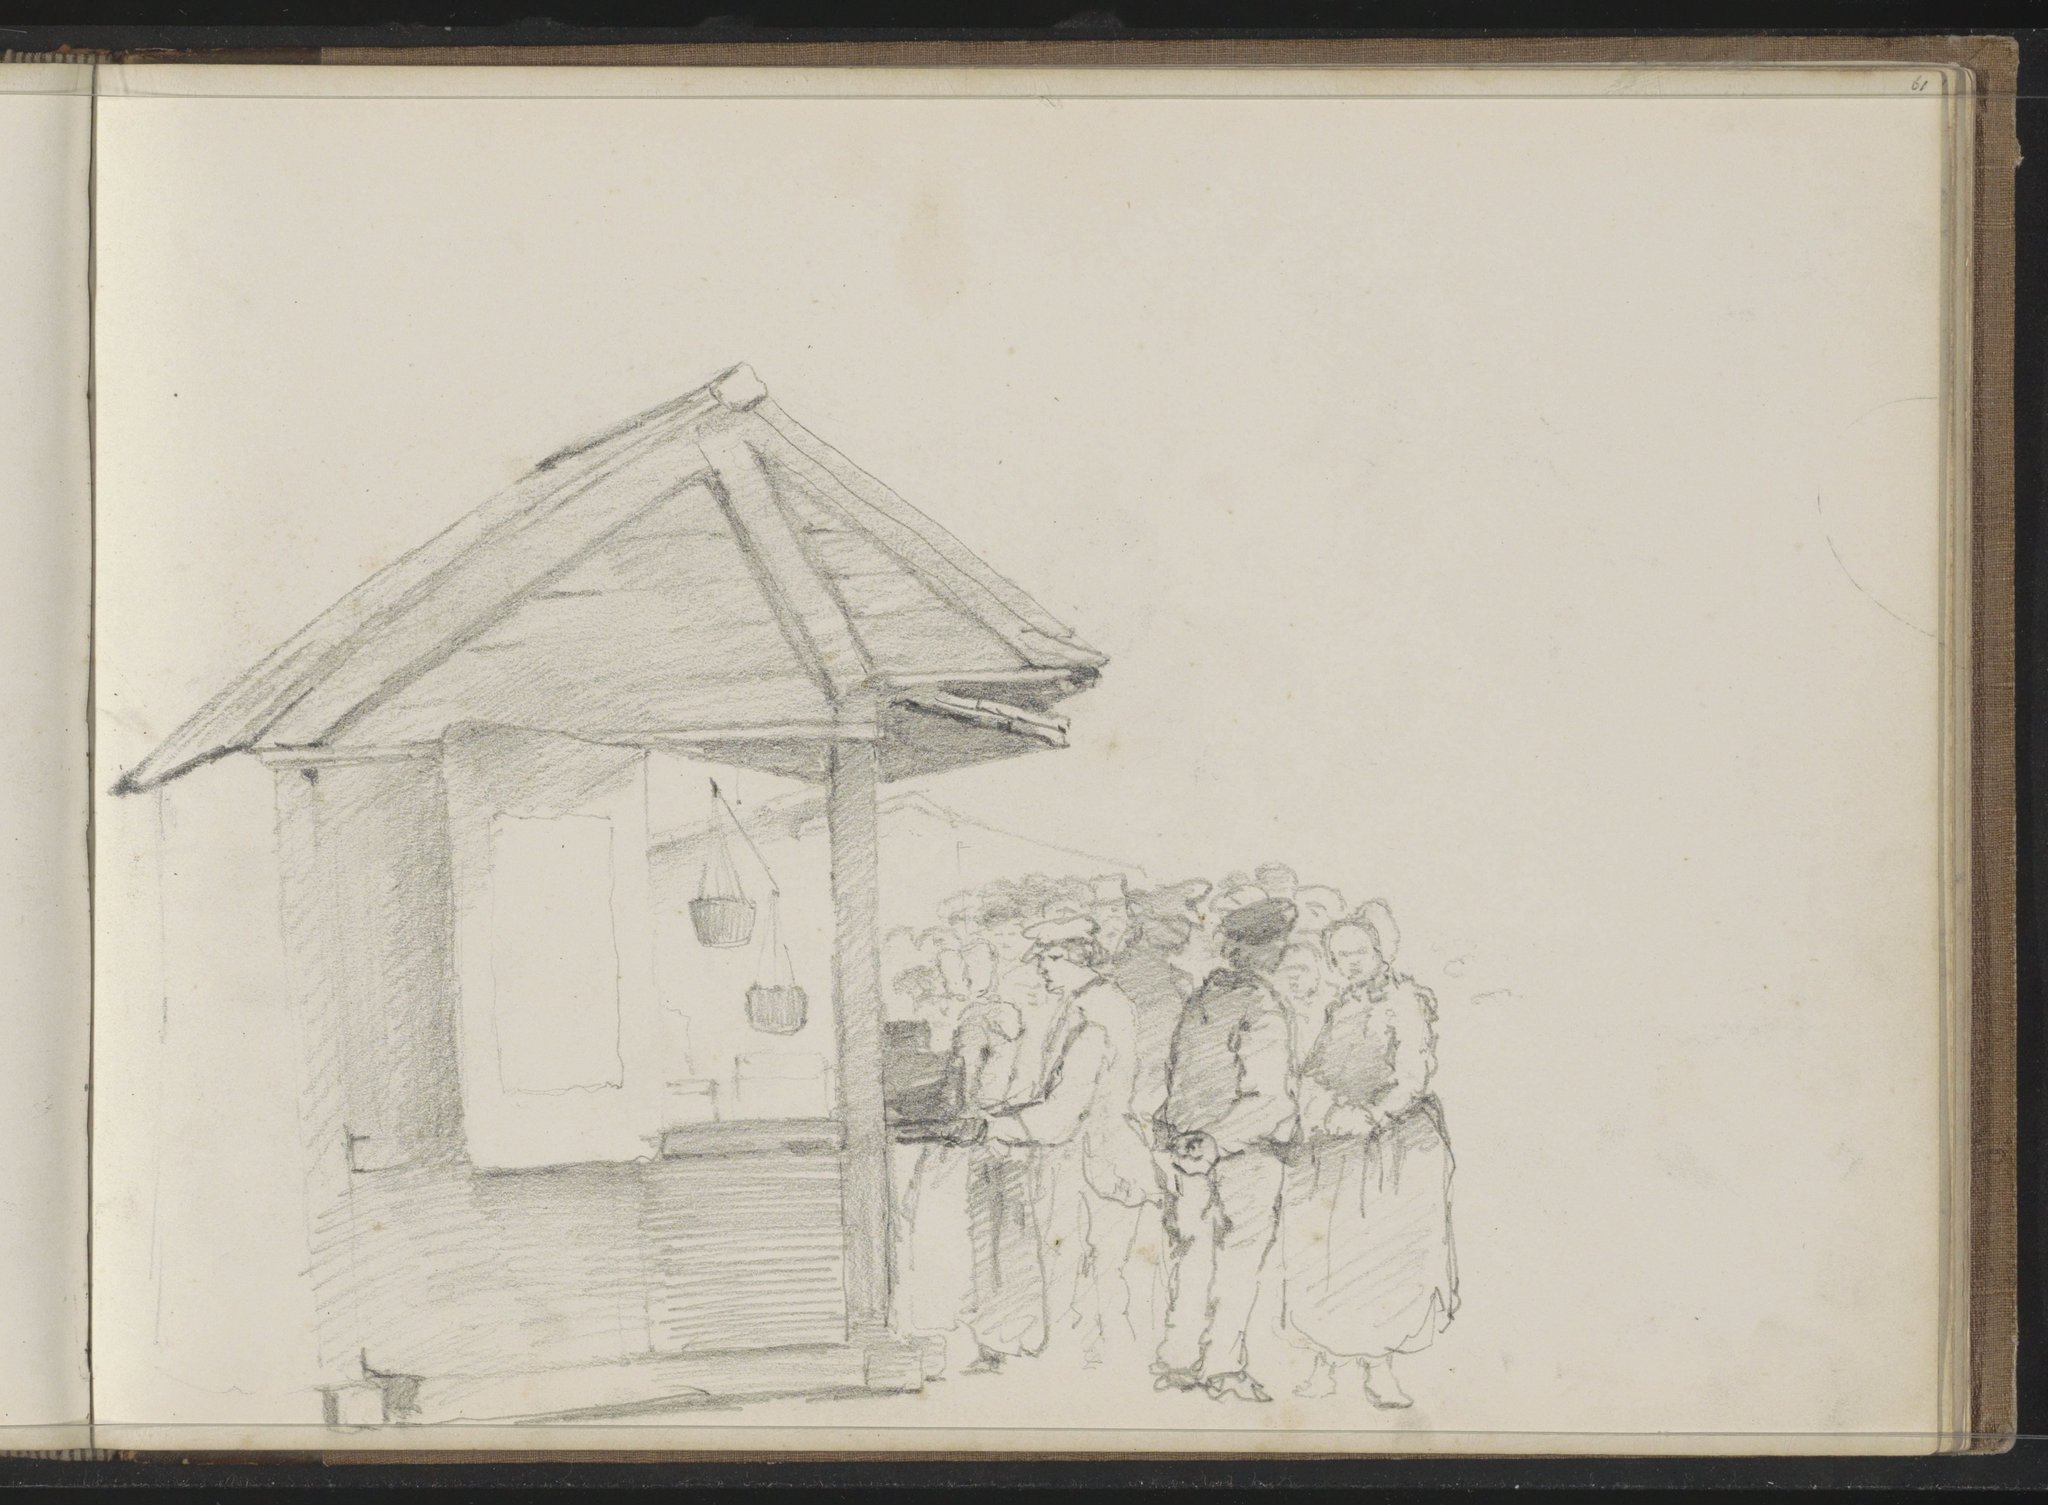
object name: sketchbook leaf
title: Rij mensen voor een kraam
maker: hendrik valkenburg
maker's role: draughtsman, painter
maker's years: 1826-1896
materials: paper, pencil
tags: crowd, mob, stall, booth (~ market)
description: Blad 61 recto uit een schetsboek met 77 bladen.